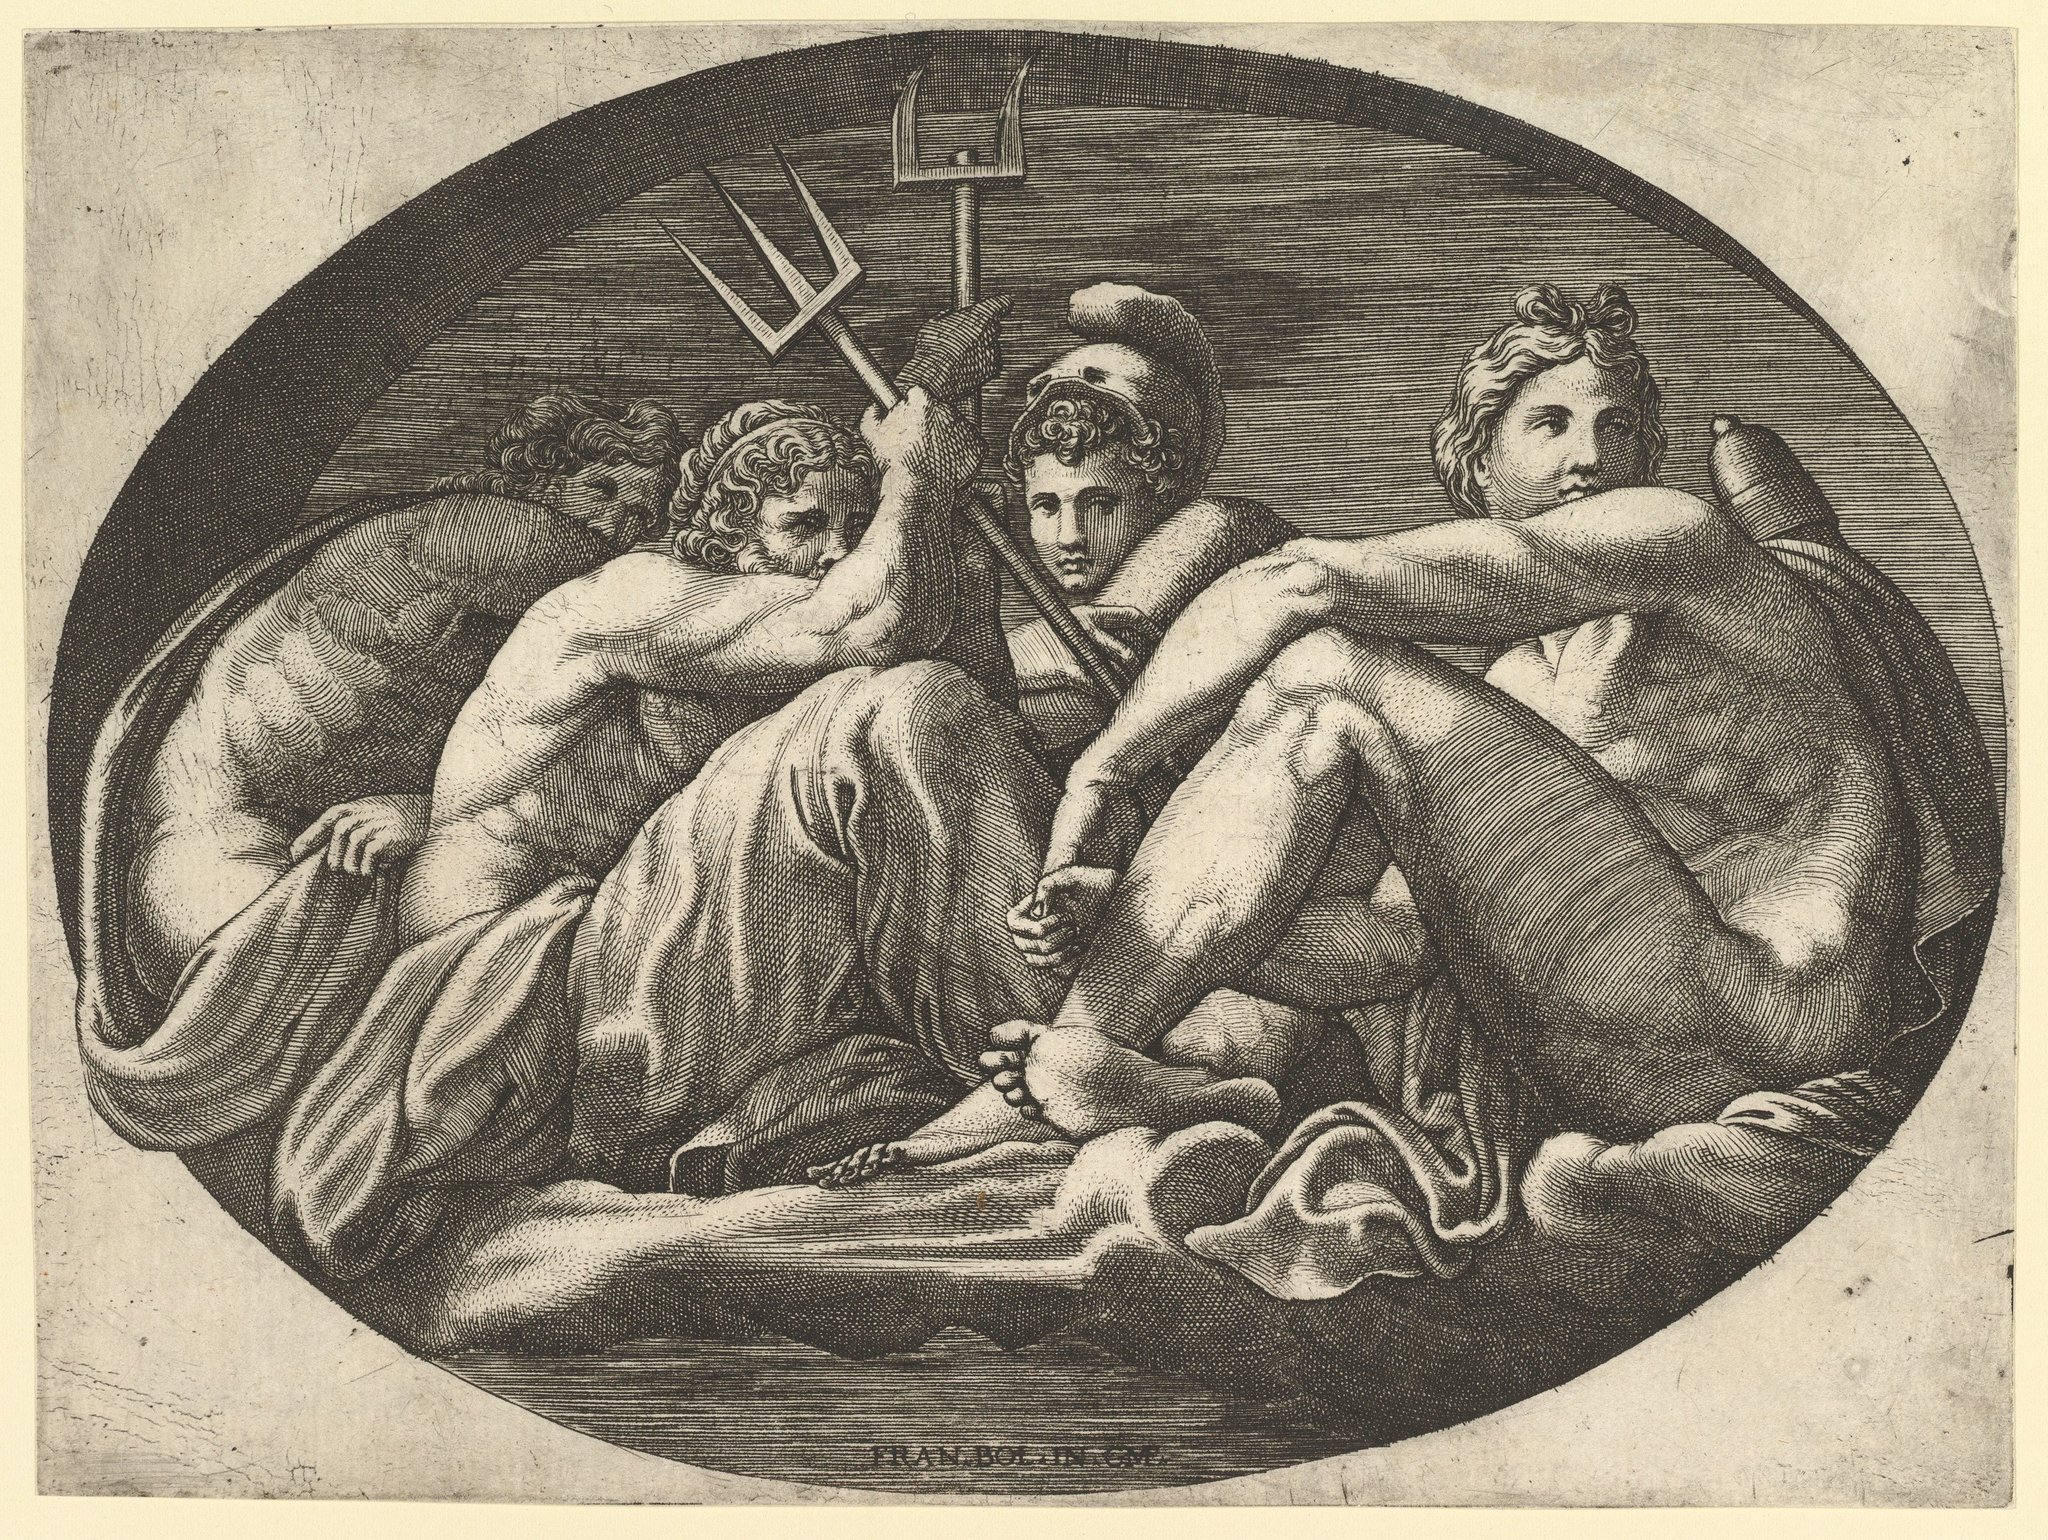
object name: print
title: Pluto, Neptune, Minerva and Apollo, from a series of eight compositions after Francesco Primaticcio's designs for the ceiling of the Ulysses Gallery (destroyed 1738-39) at Fontainebleau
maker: giorgio ghisi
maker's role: artist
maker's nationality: italian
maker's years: 1515-1582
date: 1560-1569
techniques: engraving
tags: apollo,minerva,neptune,pluto